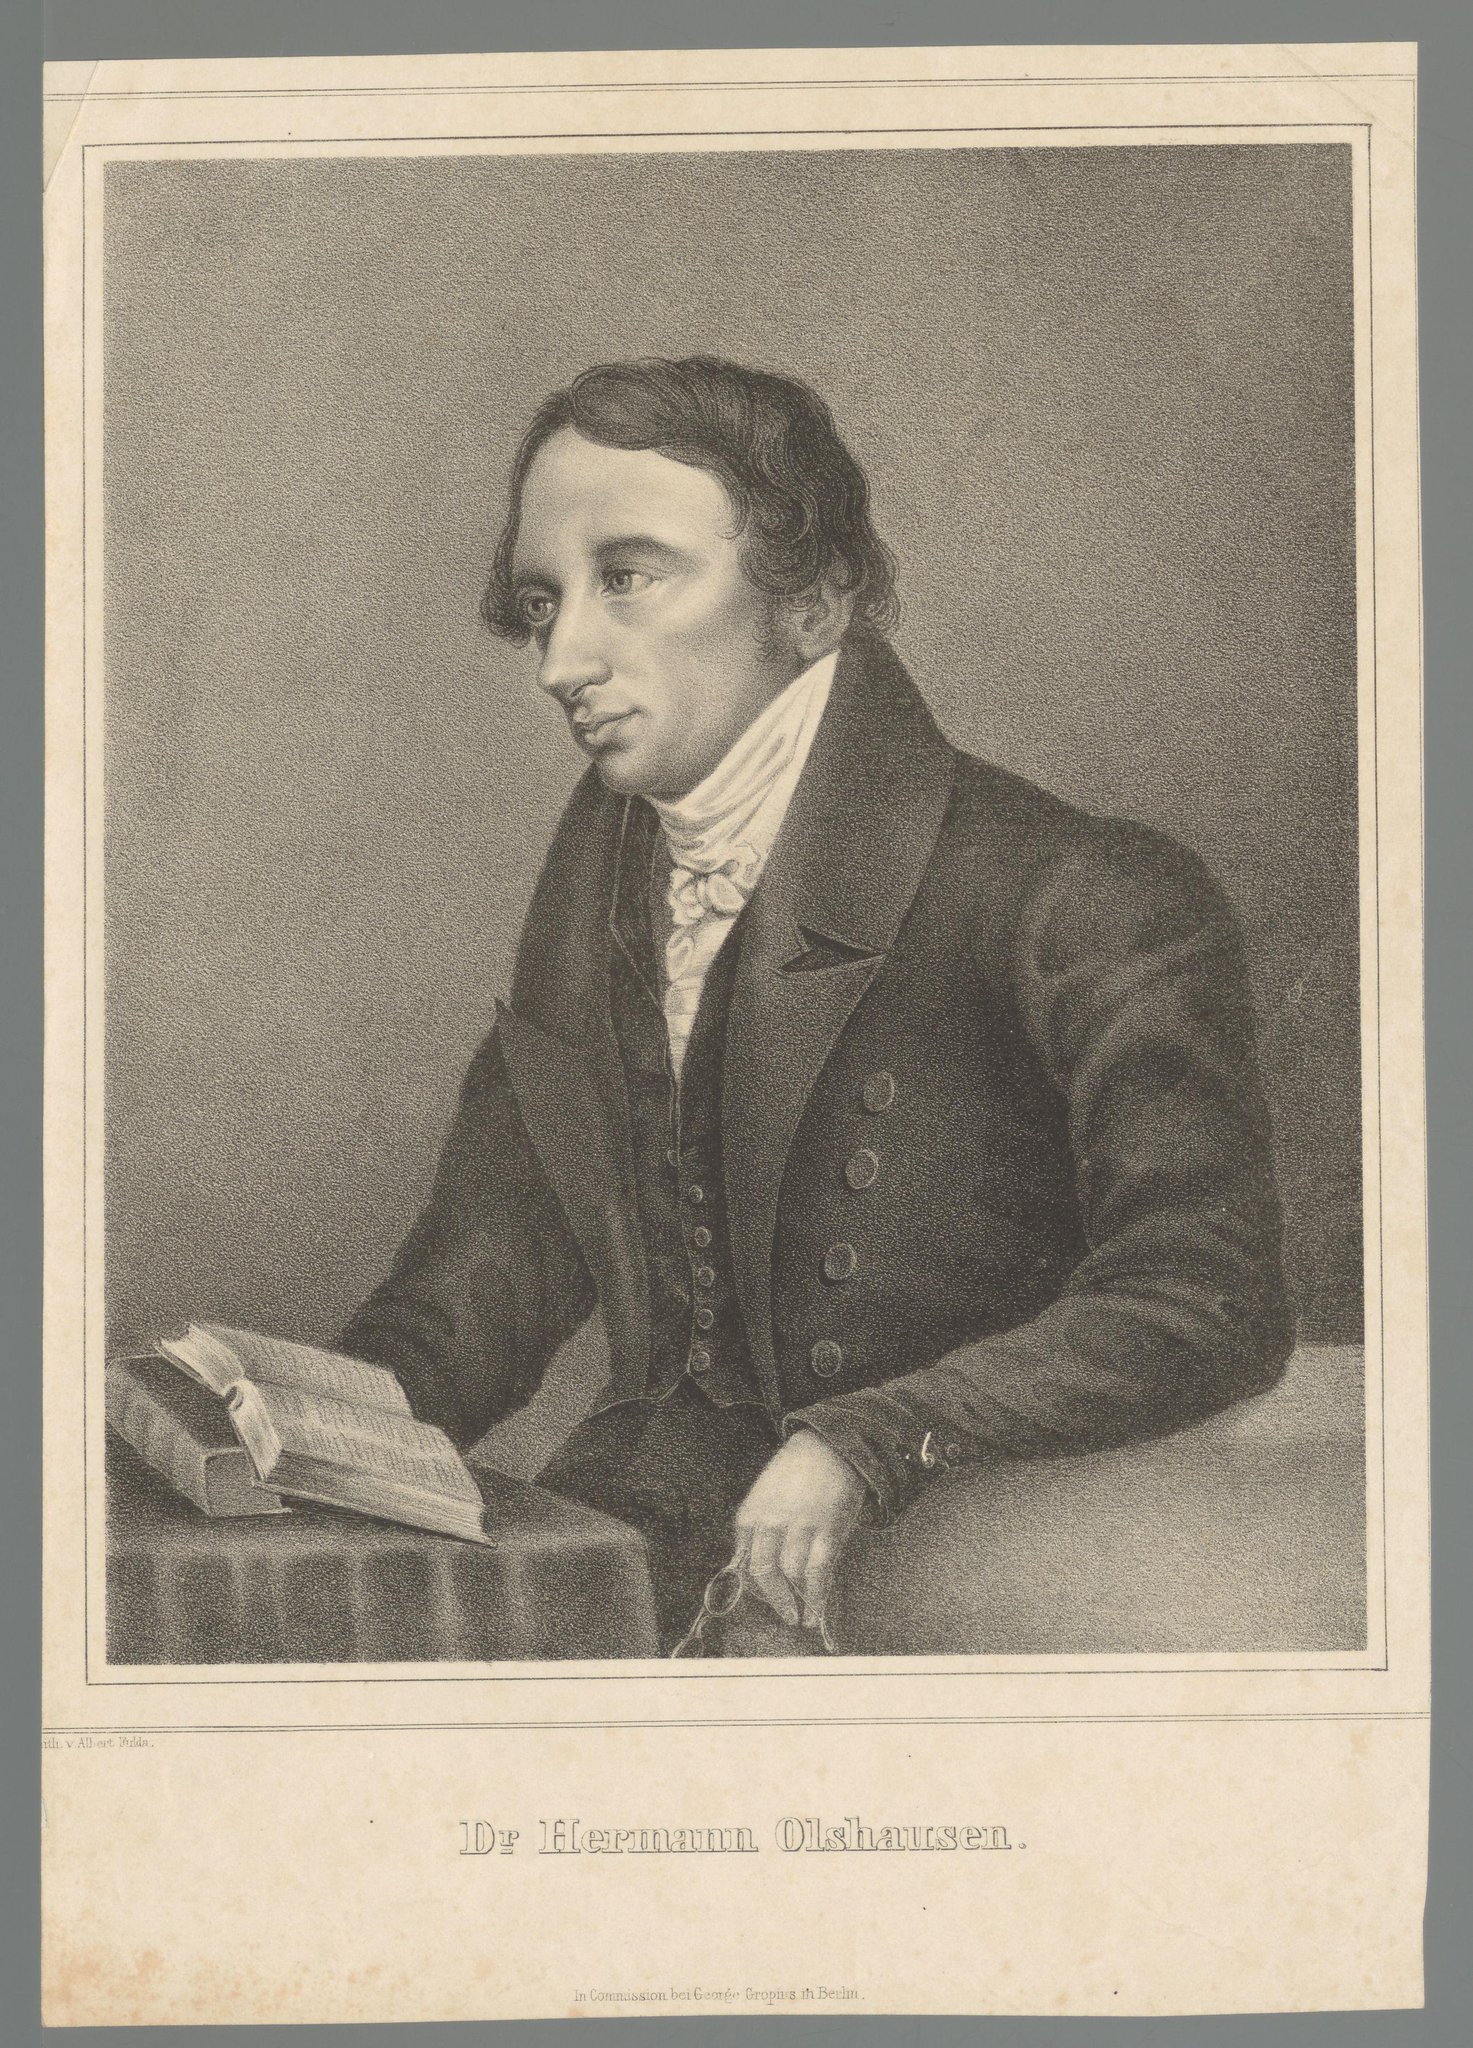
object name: print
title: Dr. Hermann Olshausen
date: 1820-1854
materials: paper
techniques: lithograph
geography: berlin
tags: adult man, historical persons, book - mm - book open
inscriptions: collector's mark: Lugt 2228